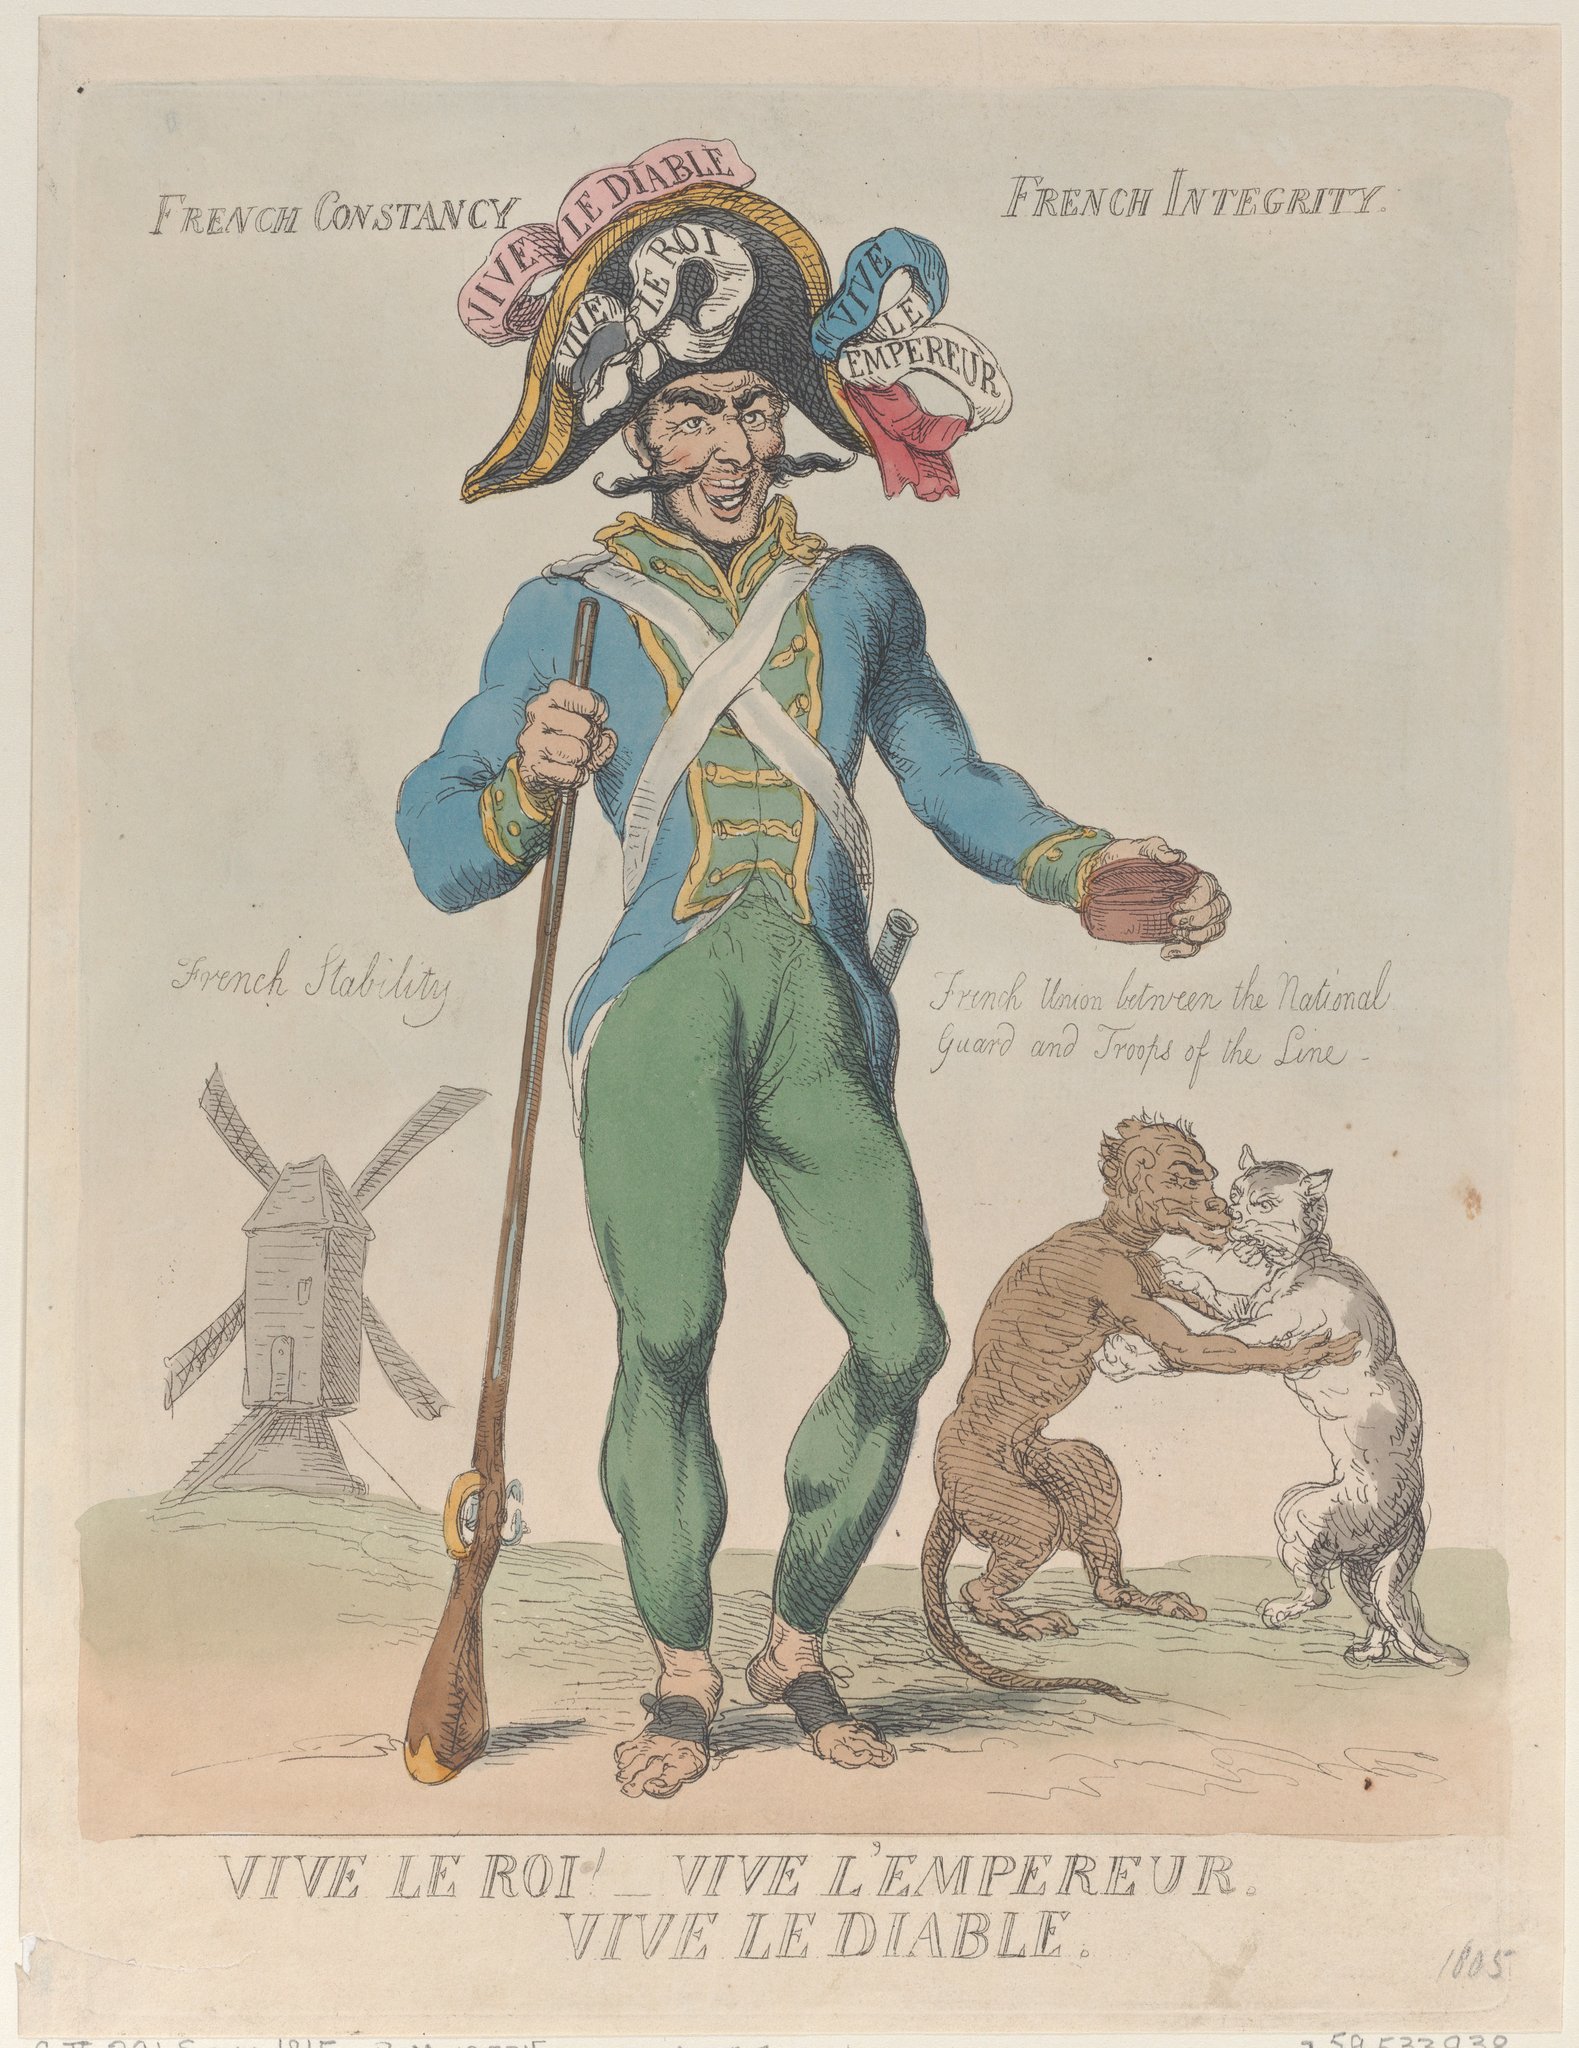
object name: print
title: Vive Le Roi! Vive L'Empereur. Vive Le Diable.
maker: thomas rowlandson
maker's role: artist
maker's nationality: british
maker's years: 1757-1827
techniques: etching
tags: satire,windmills,soldiers,men,cats,monkeys